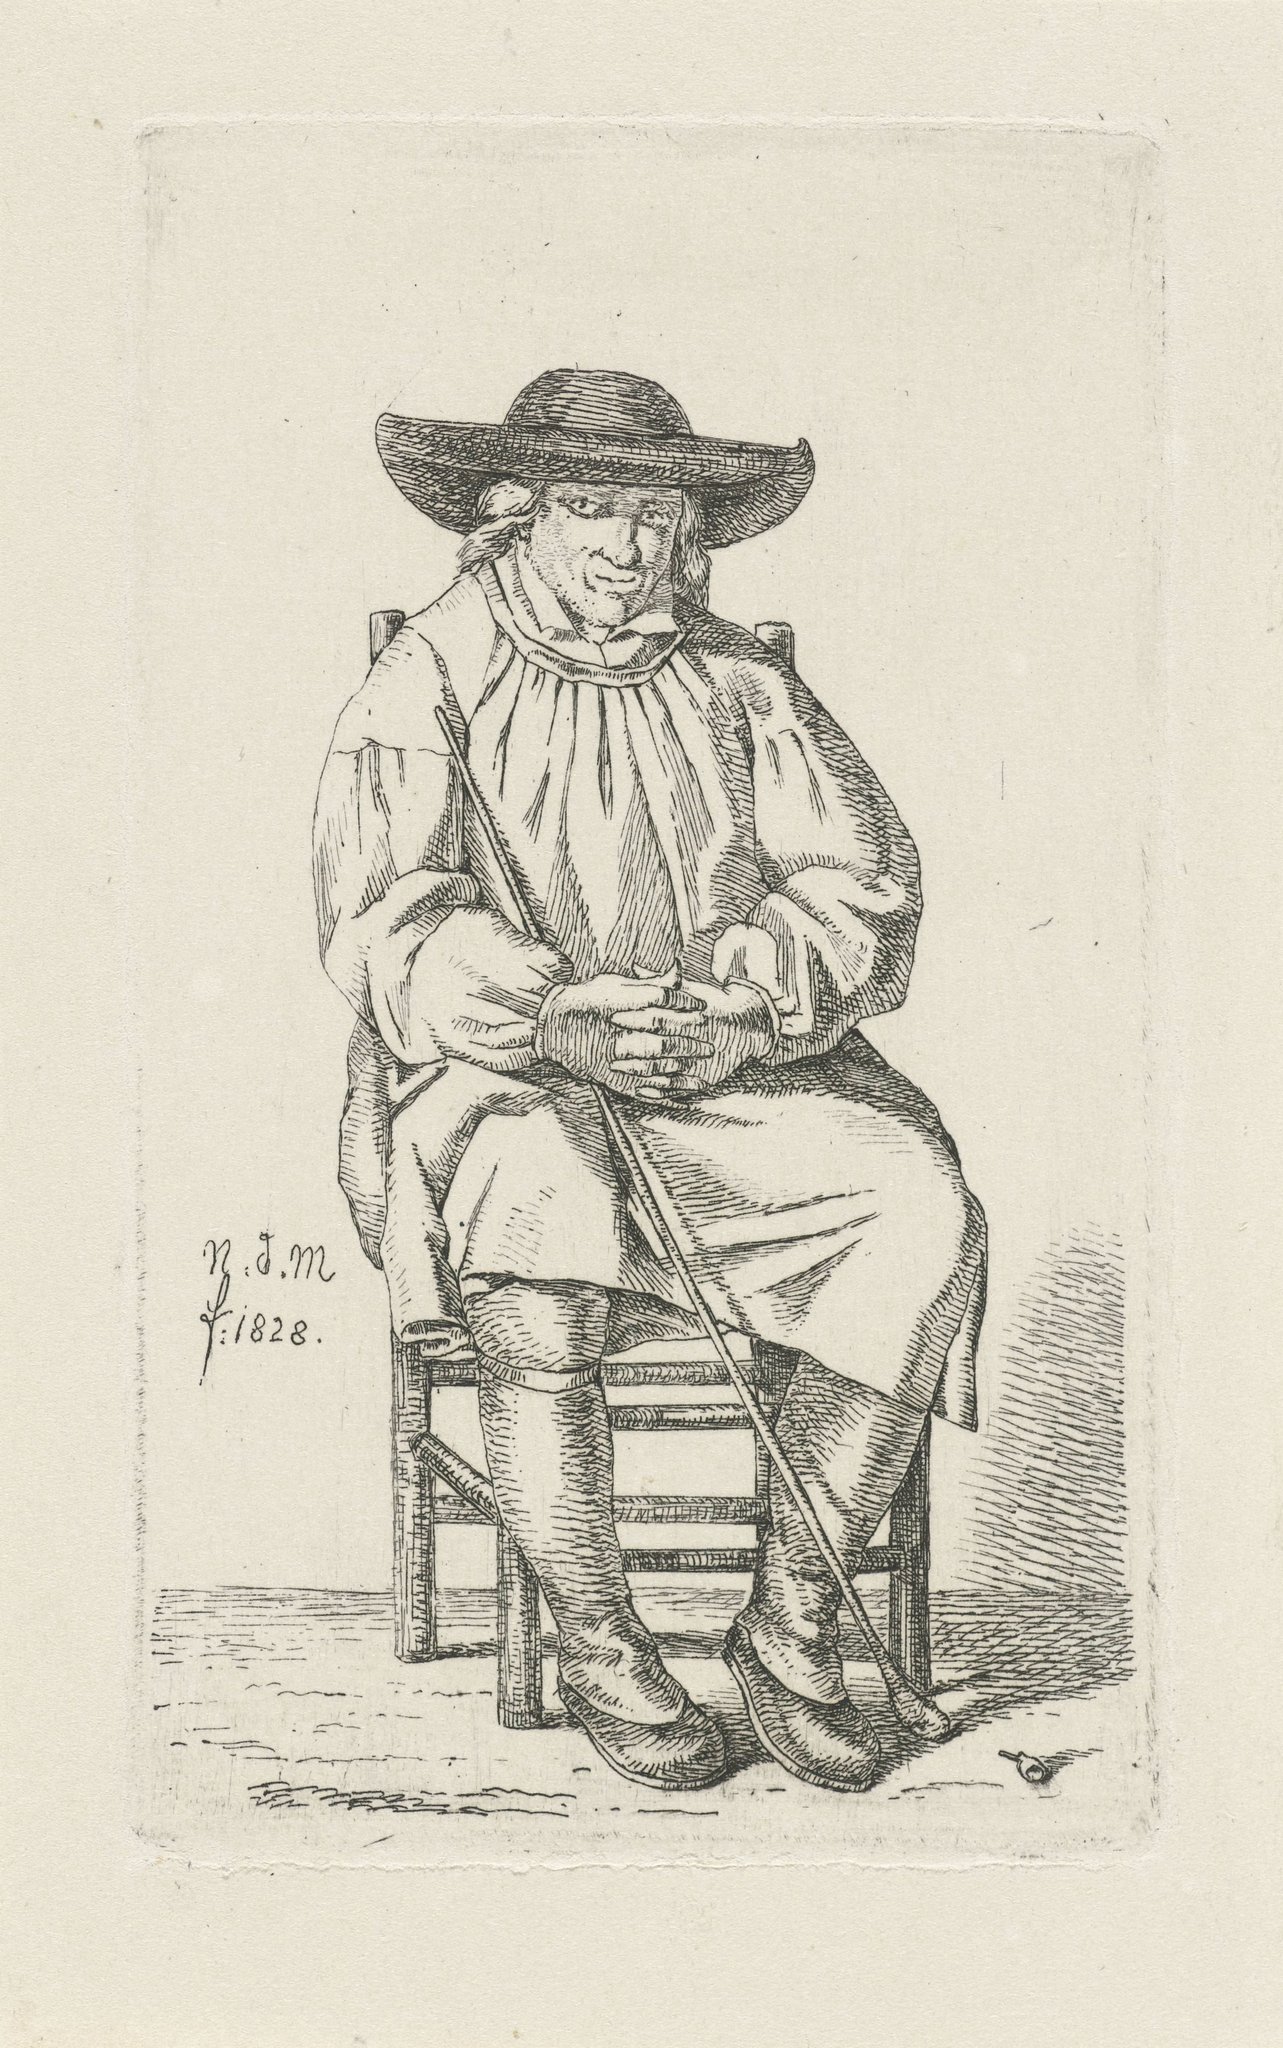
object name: print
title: 12 Studie-beeldjes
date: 1828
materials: paper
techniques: etching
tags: sitting figure, chair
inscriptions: collector's mark: Lugt 2228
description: Zittende man met stok, voor hem op de grond een klein pijpenkopje. Proefdruk van een prent uit een serie van twaalf prenten met studies van menselijke figuren.